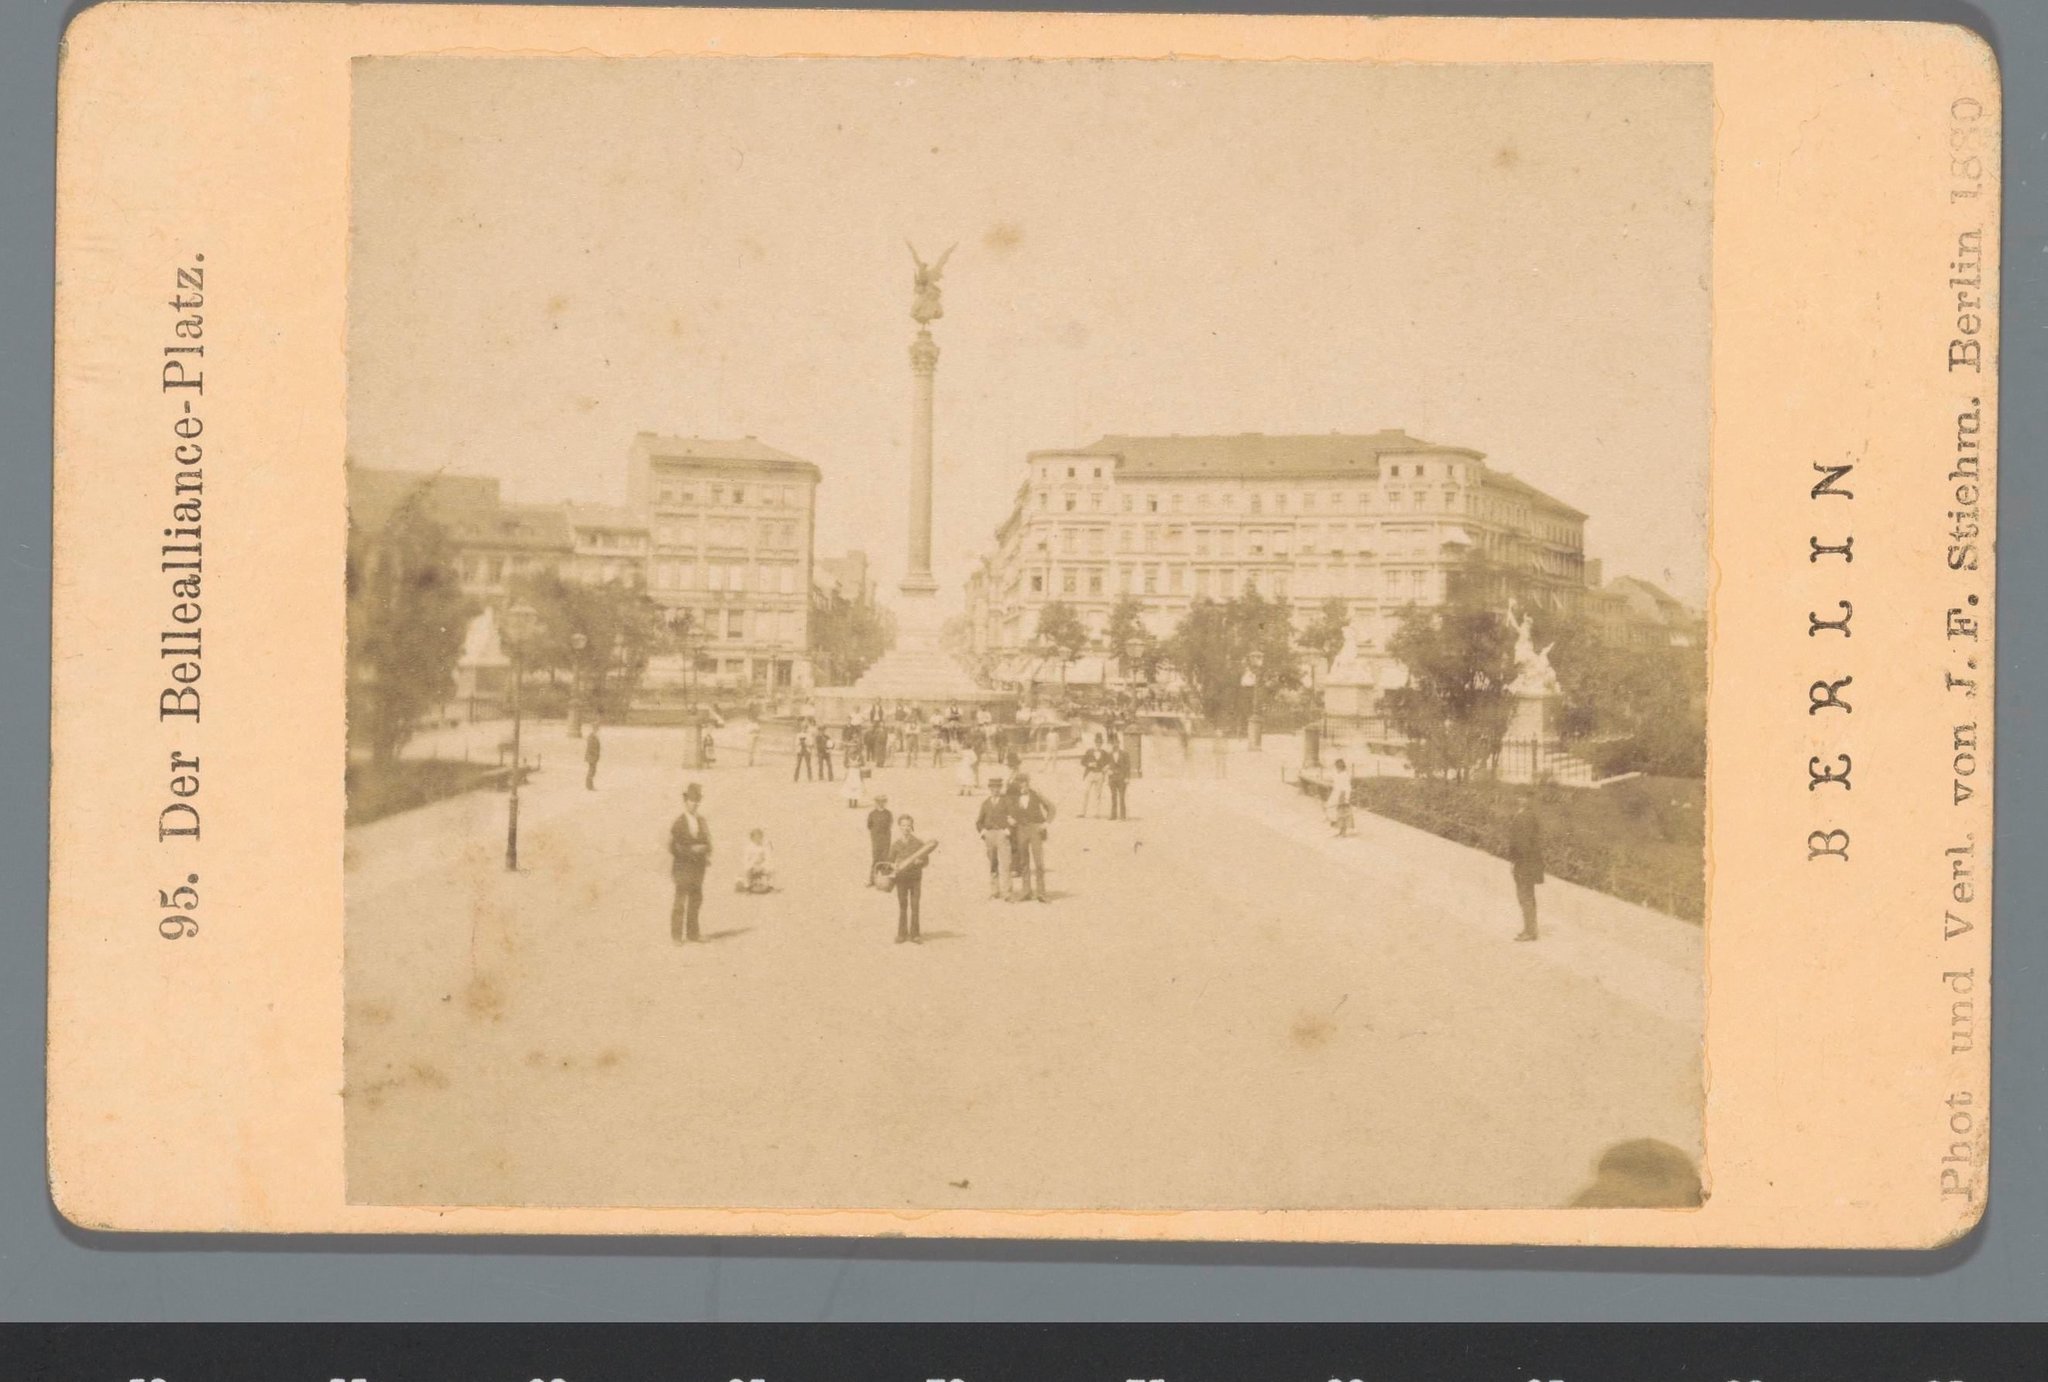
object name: carte de visite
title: Belle-Alliance-Platz, gezien richting de Friedrichstraße, Berlijn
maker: johann friedrich stiehm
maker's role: fotograaf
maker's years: 1826-1902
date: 1880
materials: cardboard, paper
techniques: albumen print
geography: berlin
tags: park, monument, statue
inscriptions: number: ‘95.’